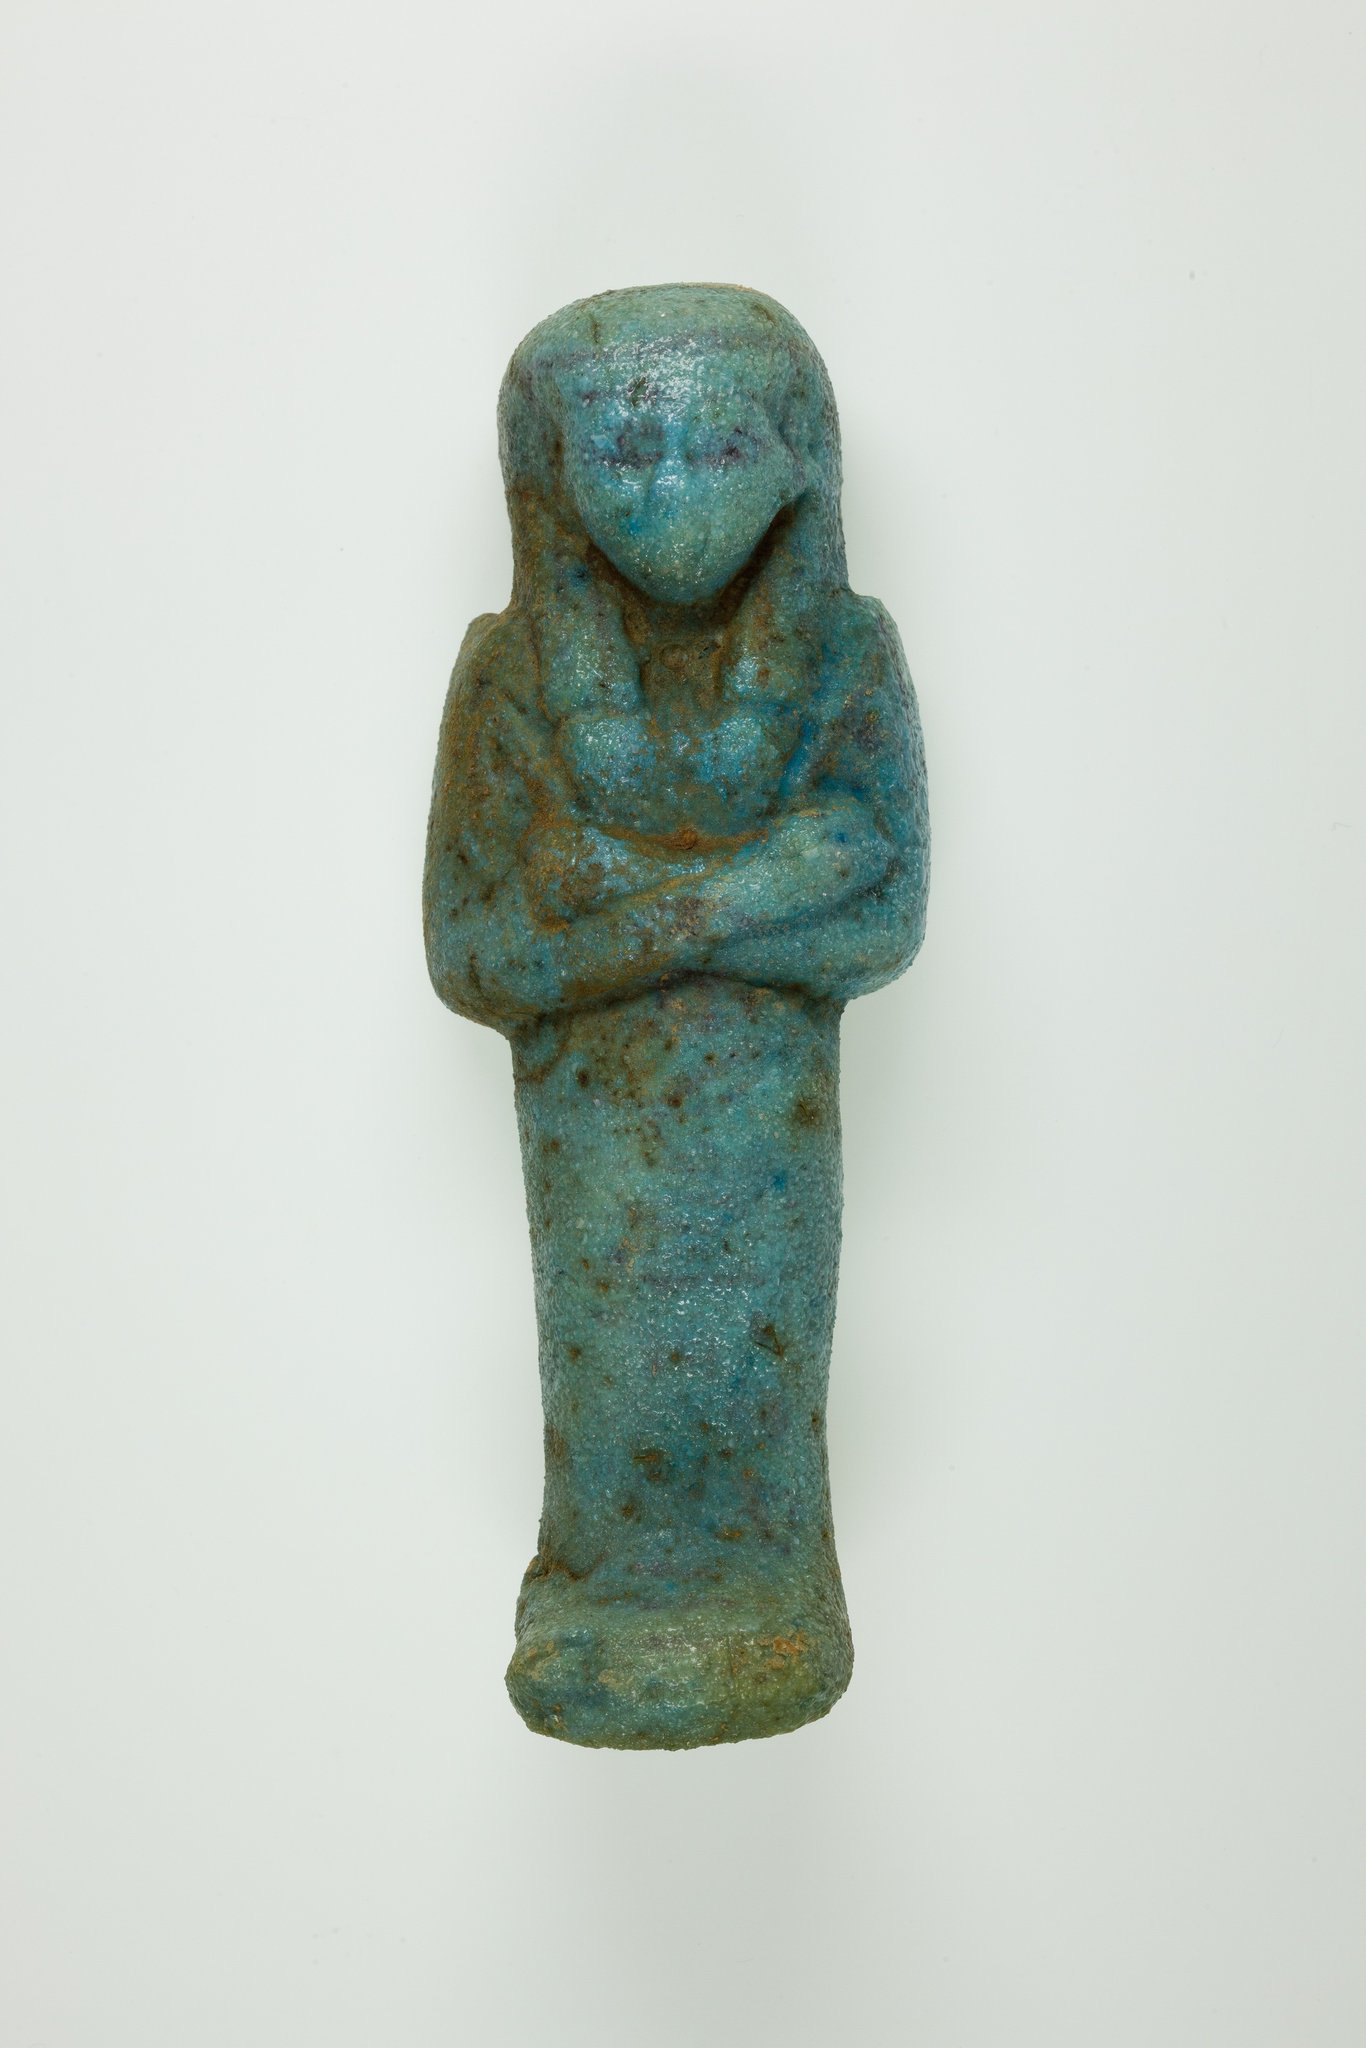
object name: worker shabti, henettawy c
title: Worker Shabti of Henettawy (C), Daughter of Isetemkheb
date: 990-970 BCE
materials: faience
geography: egypt